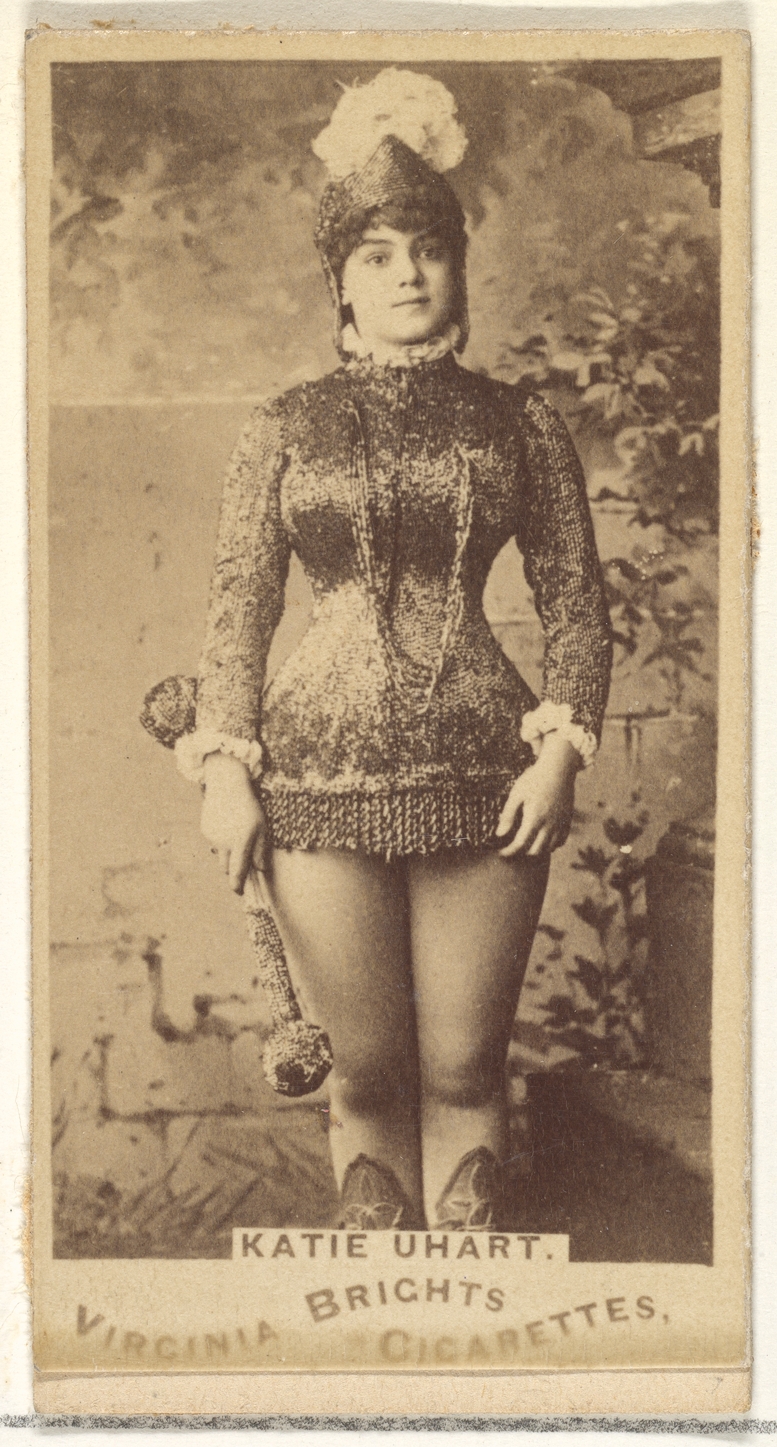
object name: photograph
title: Katie Uhart, from the Actors and Actresses series (N45, Type 1) for Virginia Brights Cigarettes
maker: allen & ginter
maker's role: publisher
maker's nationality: american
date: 1888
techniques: albumen silver print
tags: portraits,women,actresses